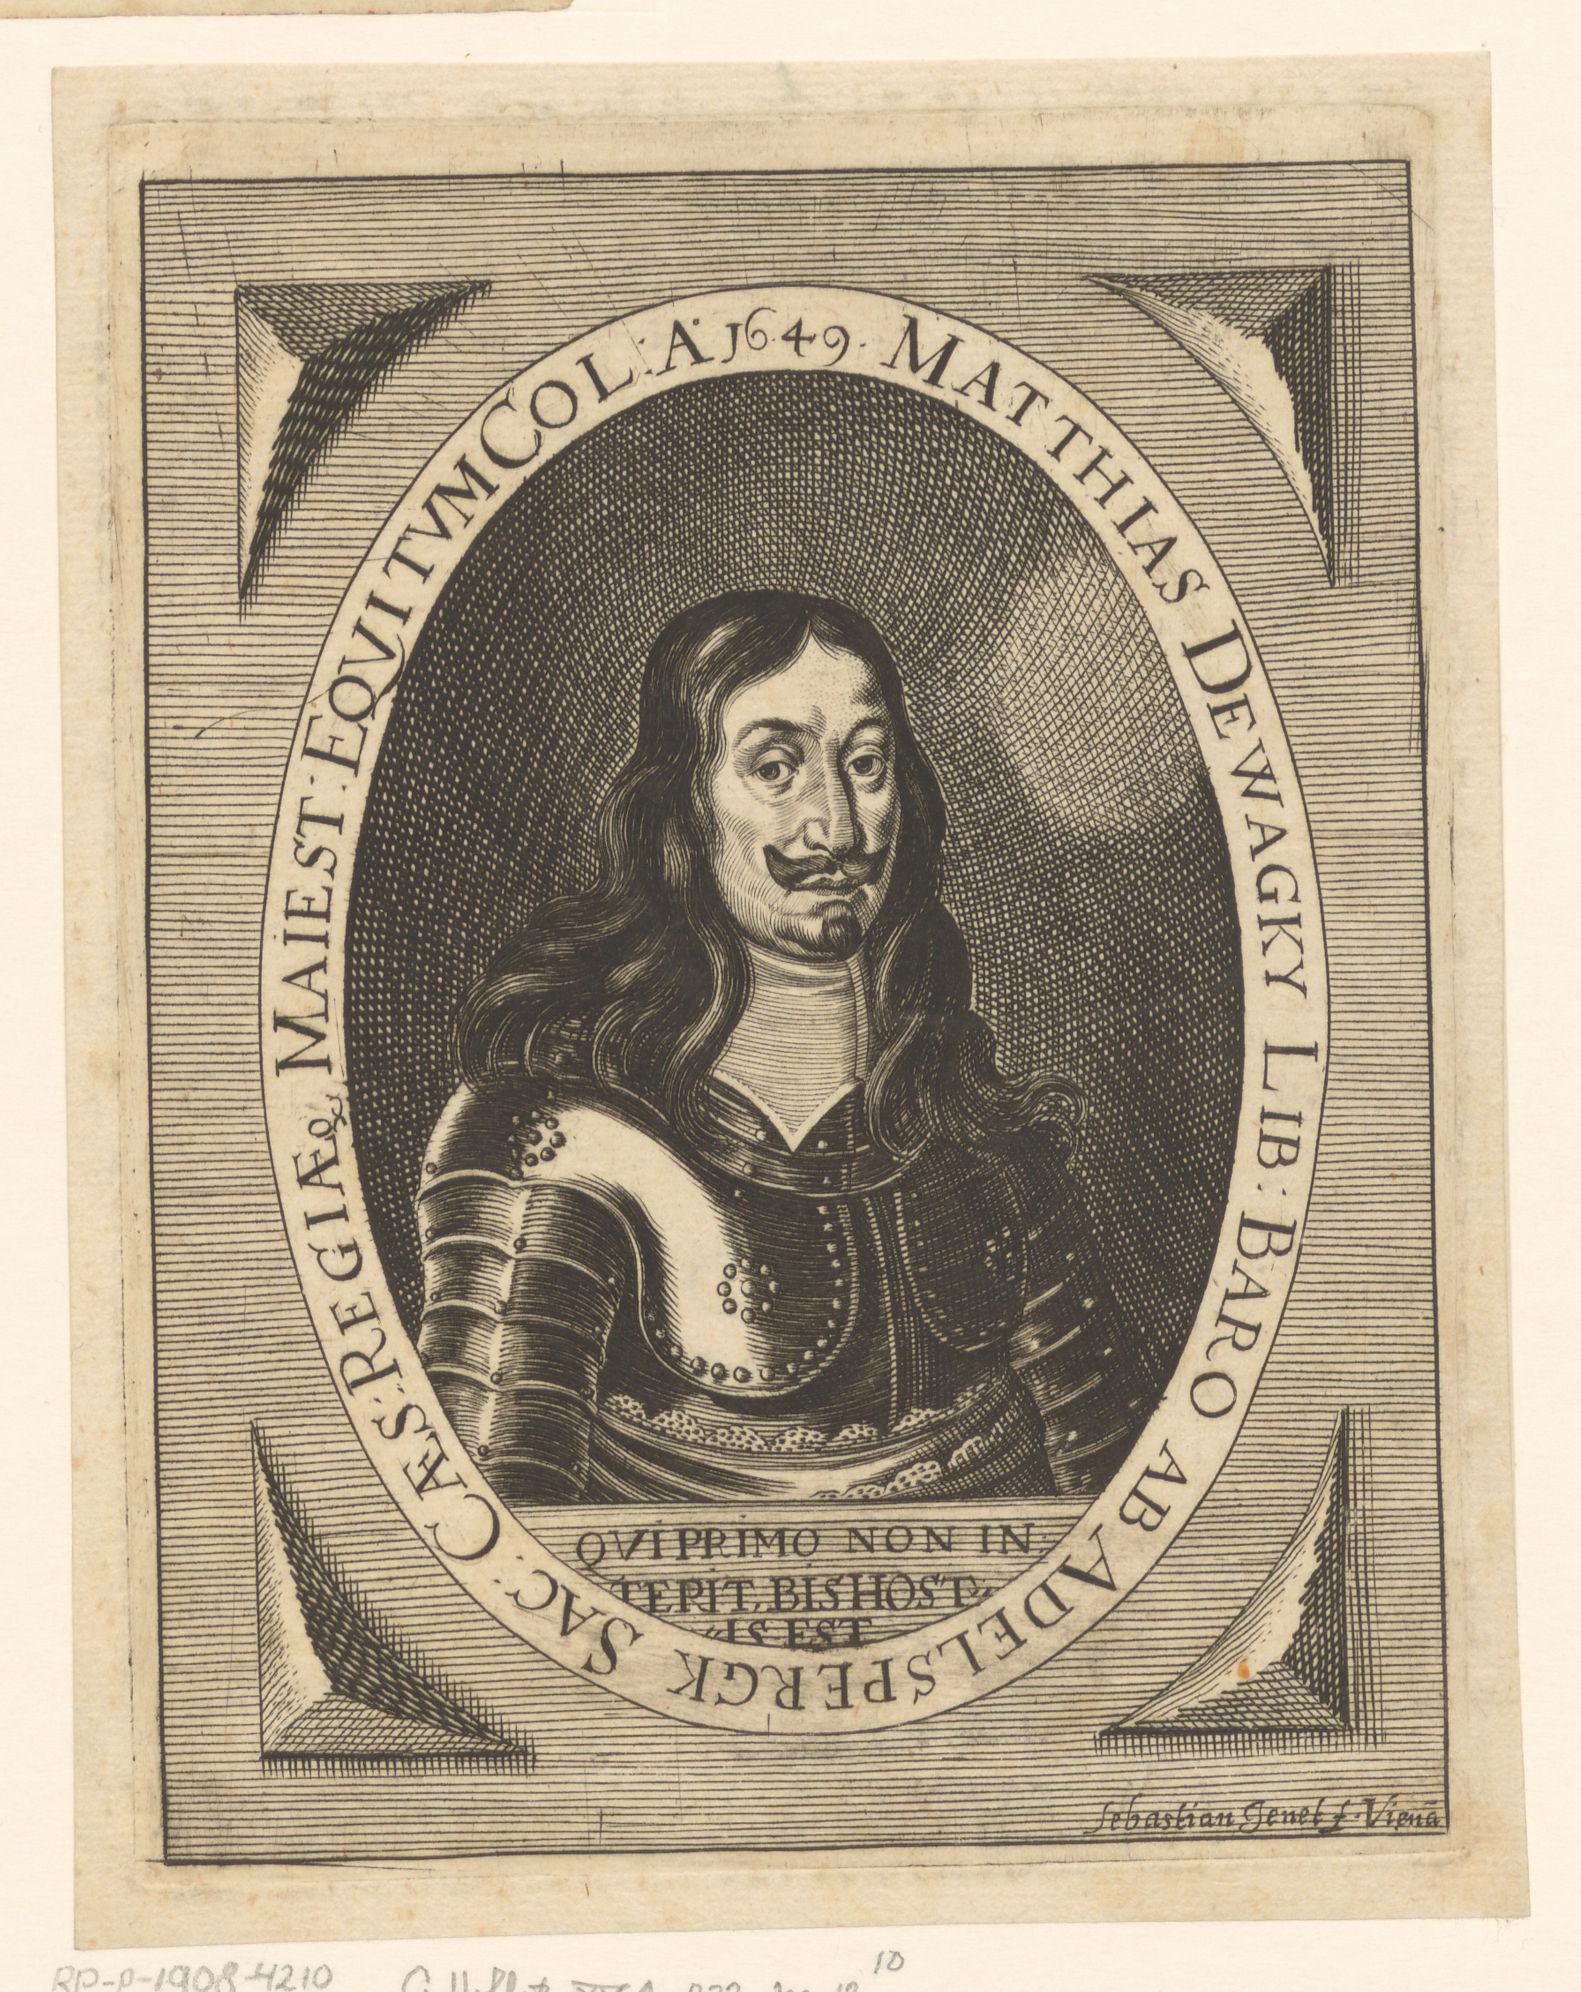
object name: print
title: Portret van Matthias Dewaggi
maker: sebastian jenet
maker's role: draughtsman, print maker, publisher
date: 1649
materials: paper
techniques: engraving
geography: vienna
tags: historical persons, officer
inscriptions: collector's mark: Lugt 2228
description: Deze prent maakt deel uit van een serie van achttien portretten voor: Widemann, Elias. Comitium Gloriae Centum Qua Sanguine Qua Virtute Illustrium Heroum Iconibus Instructum Et Excelmo. Ac Illustrissimo Heroi D.D. Joanni Christophoro Com: a Puchaim (...) Dicatum. Wenen: Matthaeus Cosmerovius, 1650.